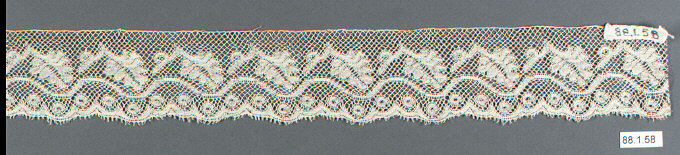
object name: piece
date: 1801-1900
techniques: lace